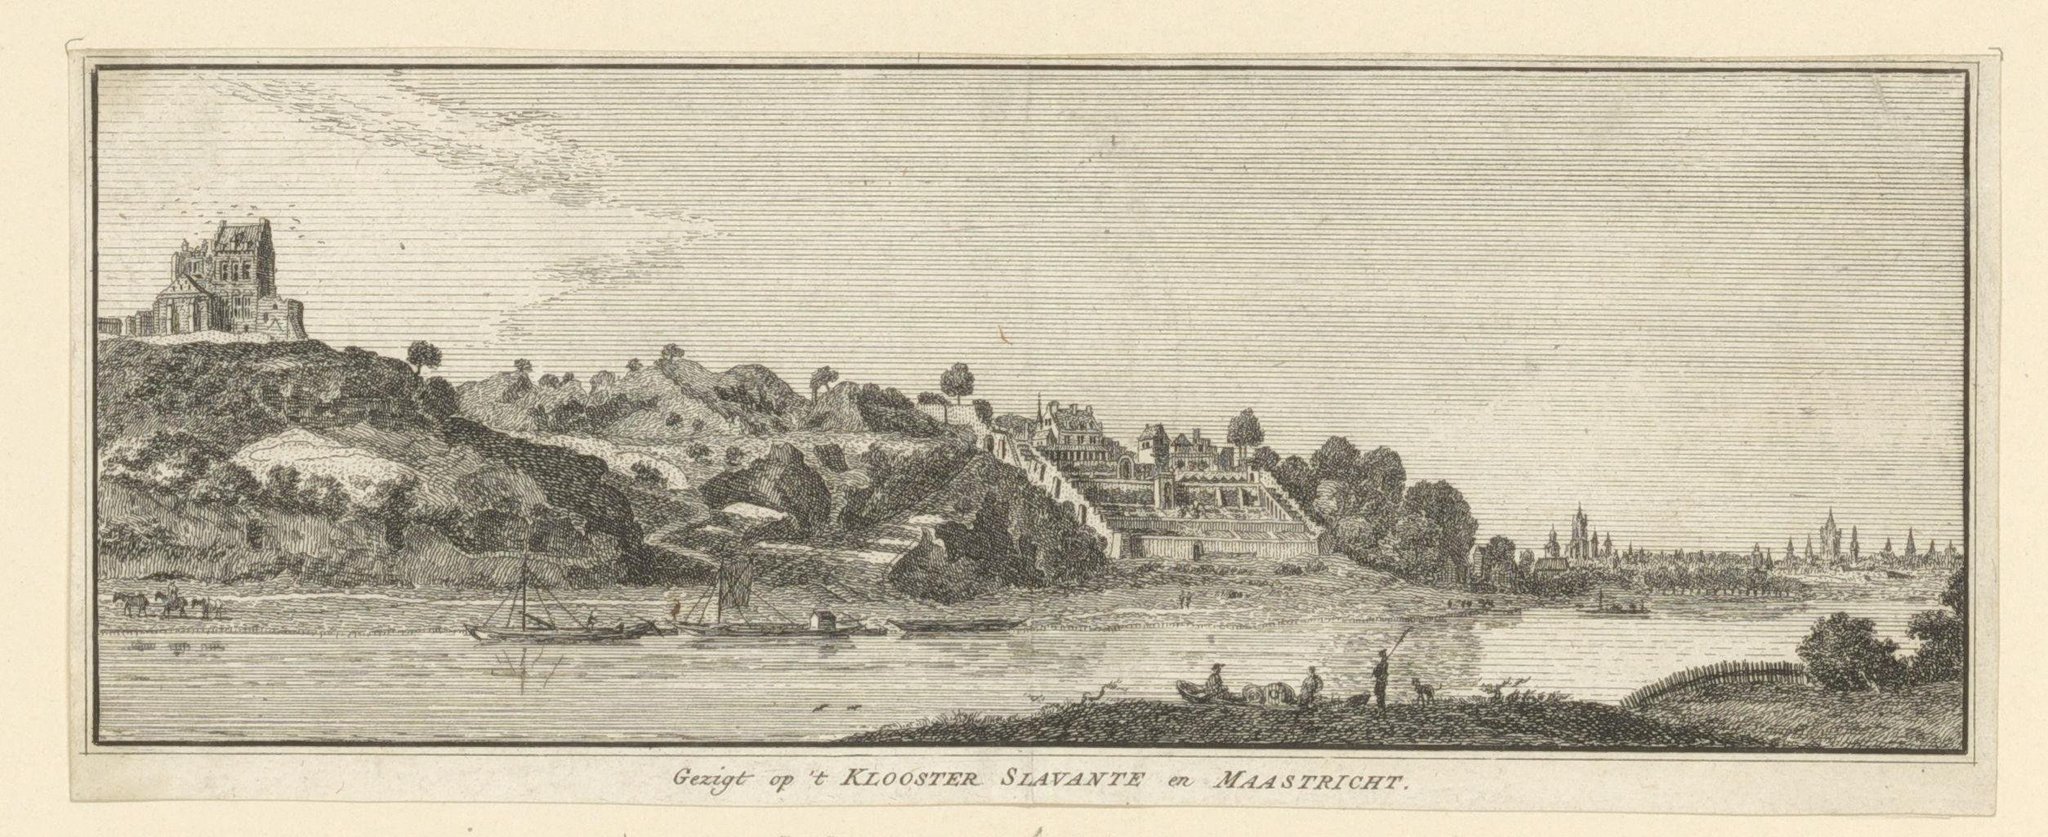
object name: print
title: Gezicht op het klooster Slavante bij Maastricht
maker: hendrik spilman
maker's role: draughtsman, painter, print maker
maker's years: 1721-1784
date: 1744-1792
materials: paper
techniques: engraving, etching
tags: cloisters ~ monastery, prospect of city, town panorama, silhouette of city, maastricht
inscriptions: collector's mark: Lugt 1641, stamp, stamp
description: Prent waarschijnlijk uit: Het verheerlykt Nederland of kabinet van hedendaagsche gezigten van steden, dorpen (…). 9 dln. Amsterdam: Isaak Tirion en weduwe Isaak Tirion, 1745-1774, dl. 2 (1746). Of uit: Nederlandsche tafereelen; of eene keurige verzameling van negen honderd fraaije gezigten van steden, dorpen, sloten, oudheden (….). 9 dln. Amsterdam: Jan de Groot, 1792, dl. 2.